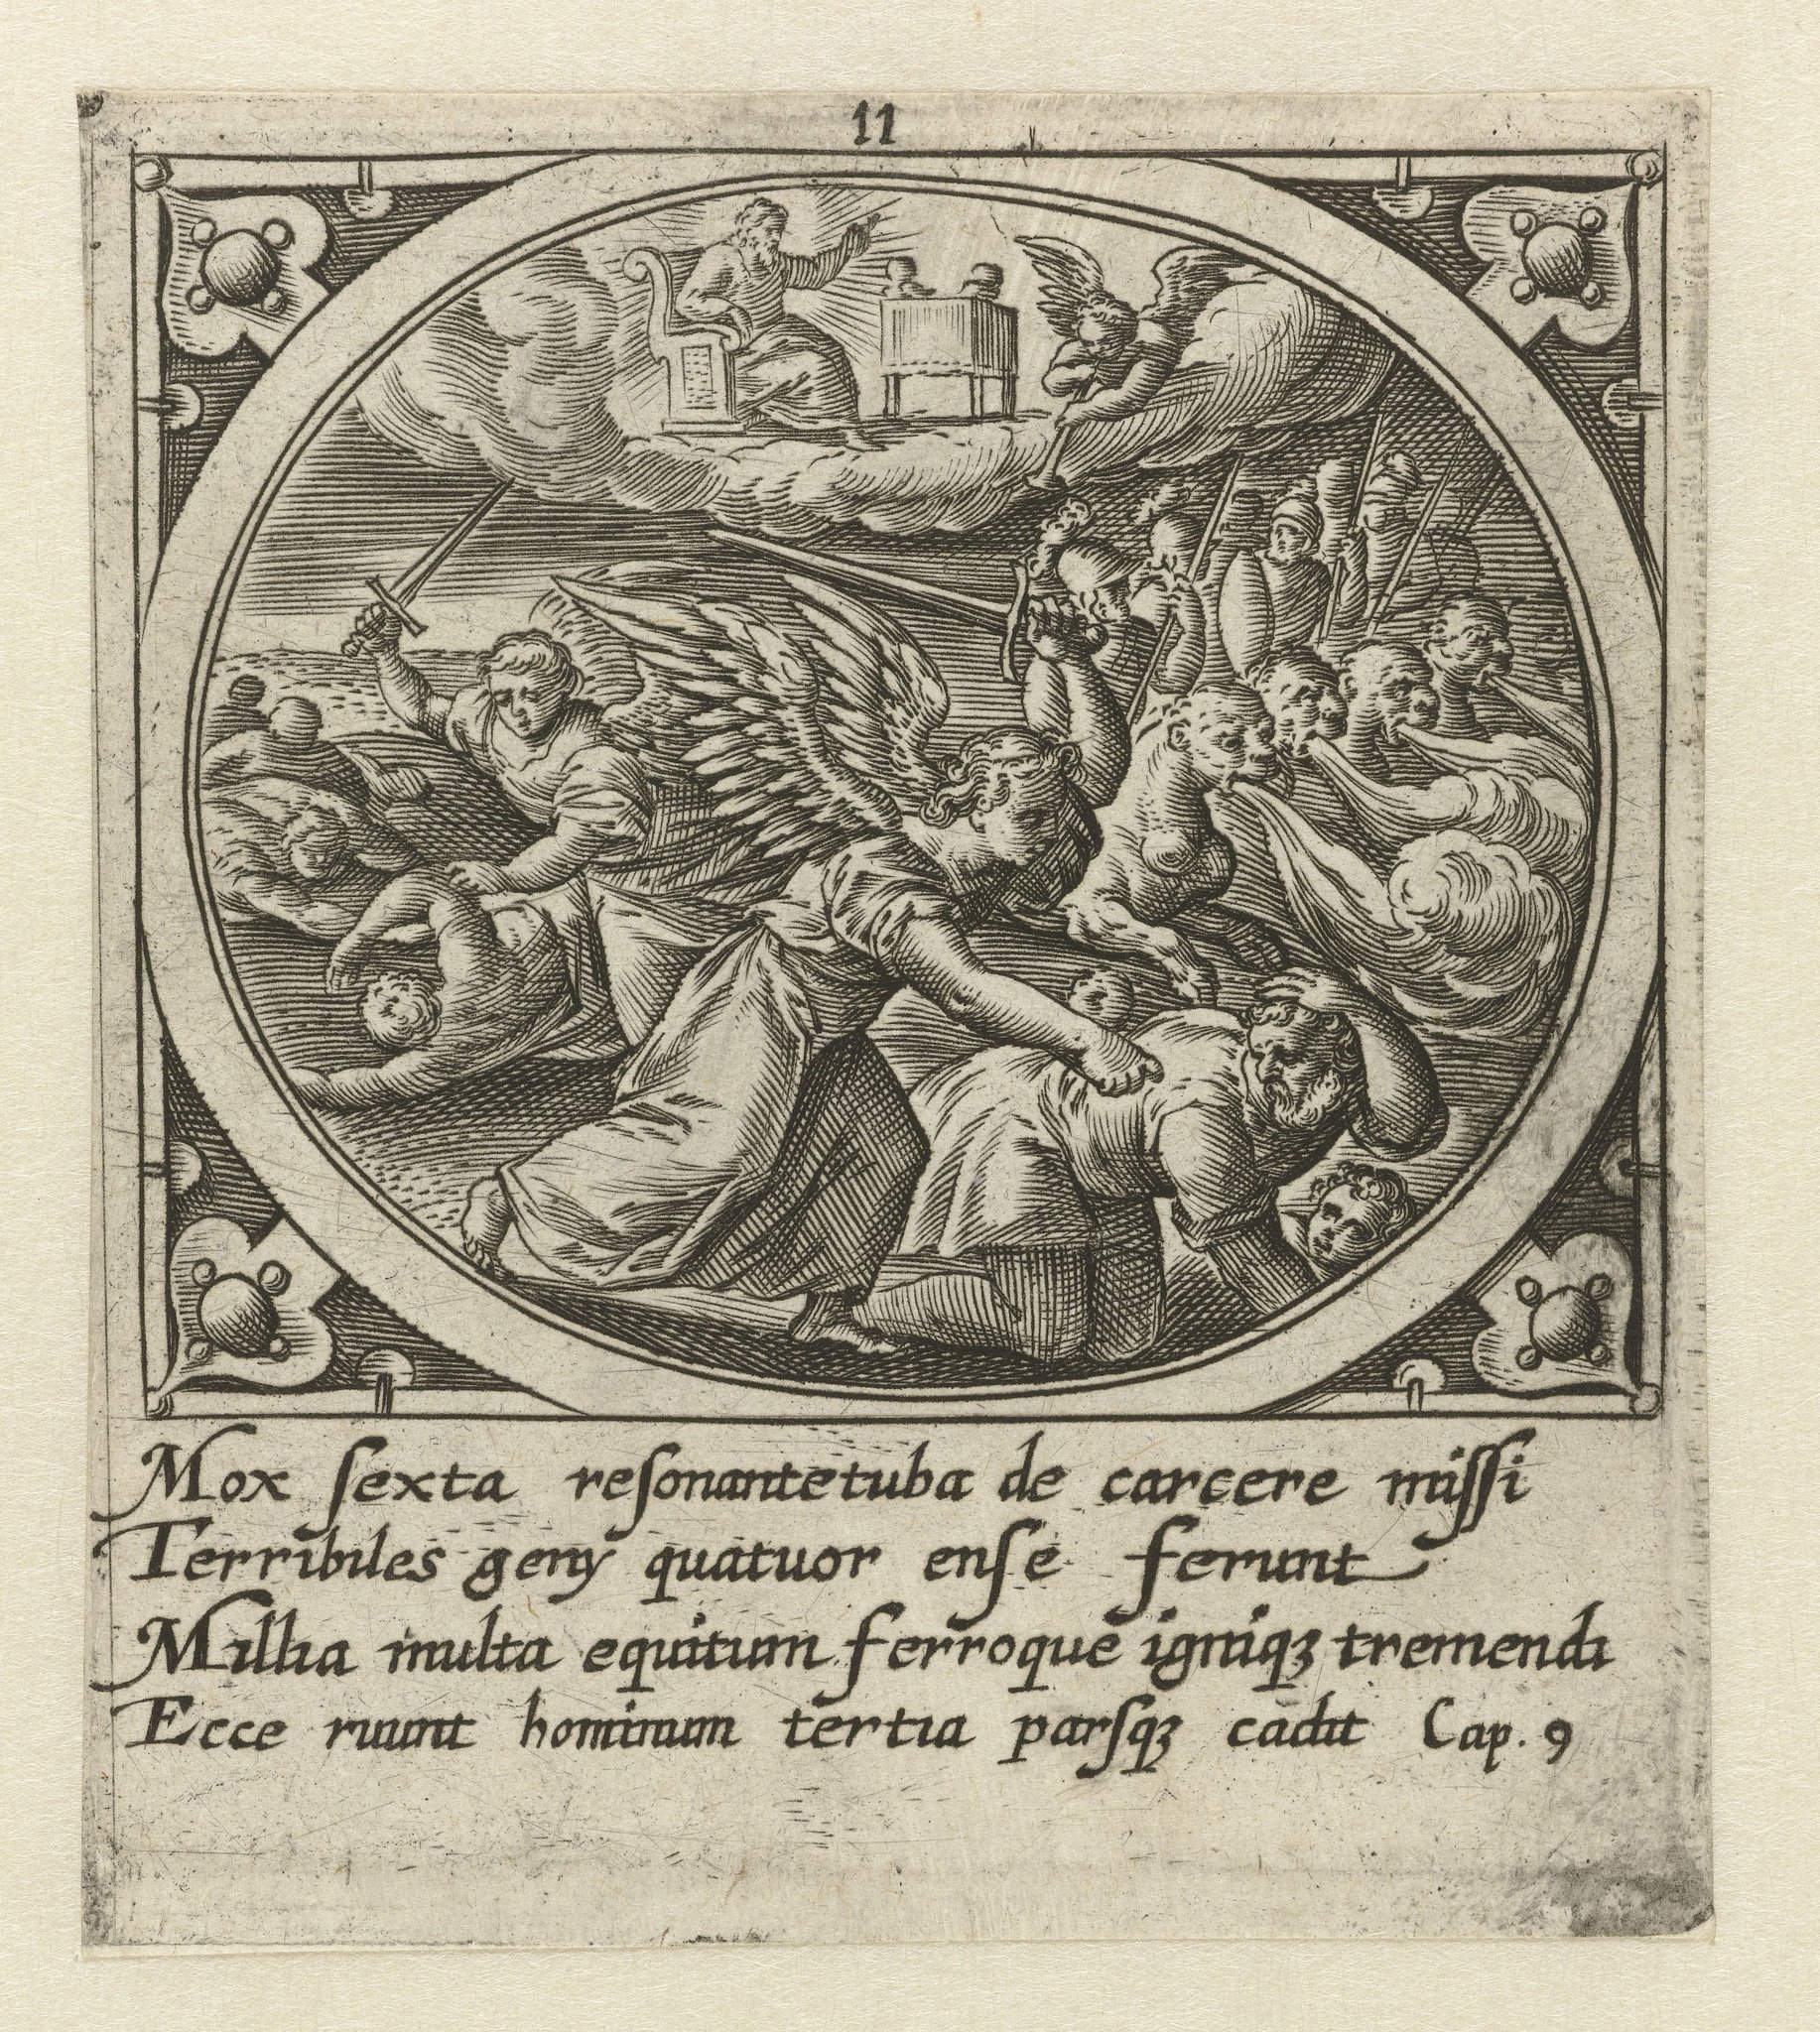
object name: print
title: Zesde engel blaast op bazuin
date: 1585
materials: paper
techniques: engraving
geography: antwerp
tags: the sixth of the seven angels sounds the trumpet: the four angels of destruction are released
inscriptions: collector's mark: Lugt 2760, collector's mark: Lugt 2228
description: De zesde engel blaast op de bazuin. Naast de engel zit God de Vader op zijn troon en staat het gouden altaar met de vier horens waar een stem uitkomt die opdraagt dat de vier engelen die gevangen zitten moeten worden bevrijd. De engelen en de ruiters op paarden met leeuwenkoppen roeien een derde van de mensheid uit. In de marge een vierregelig onderschrift in het Latijn. Elfde prent uit een serie van vierentwintig met de openbaring van Johannes op Patmos.